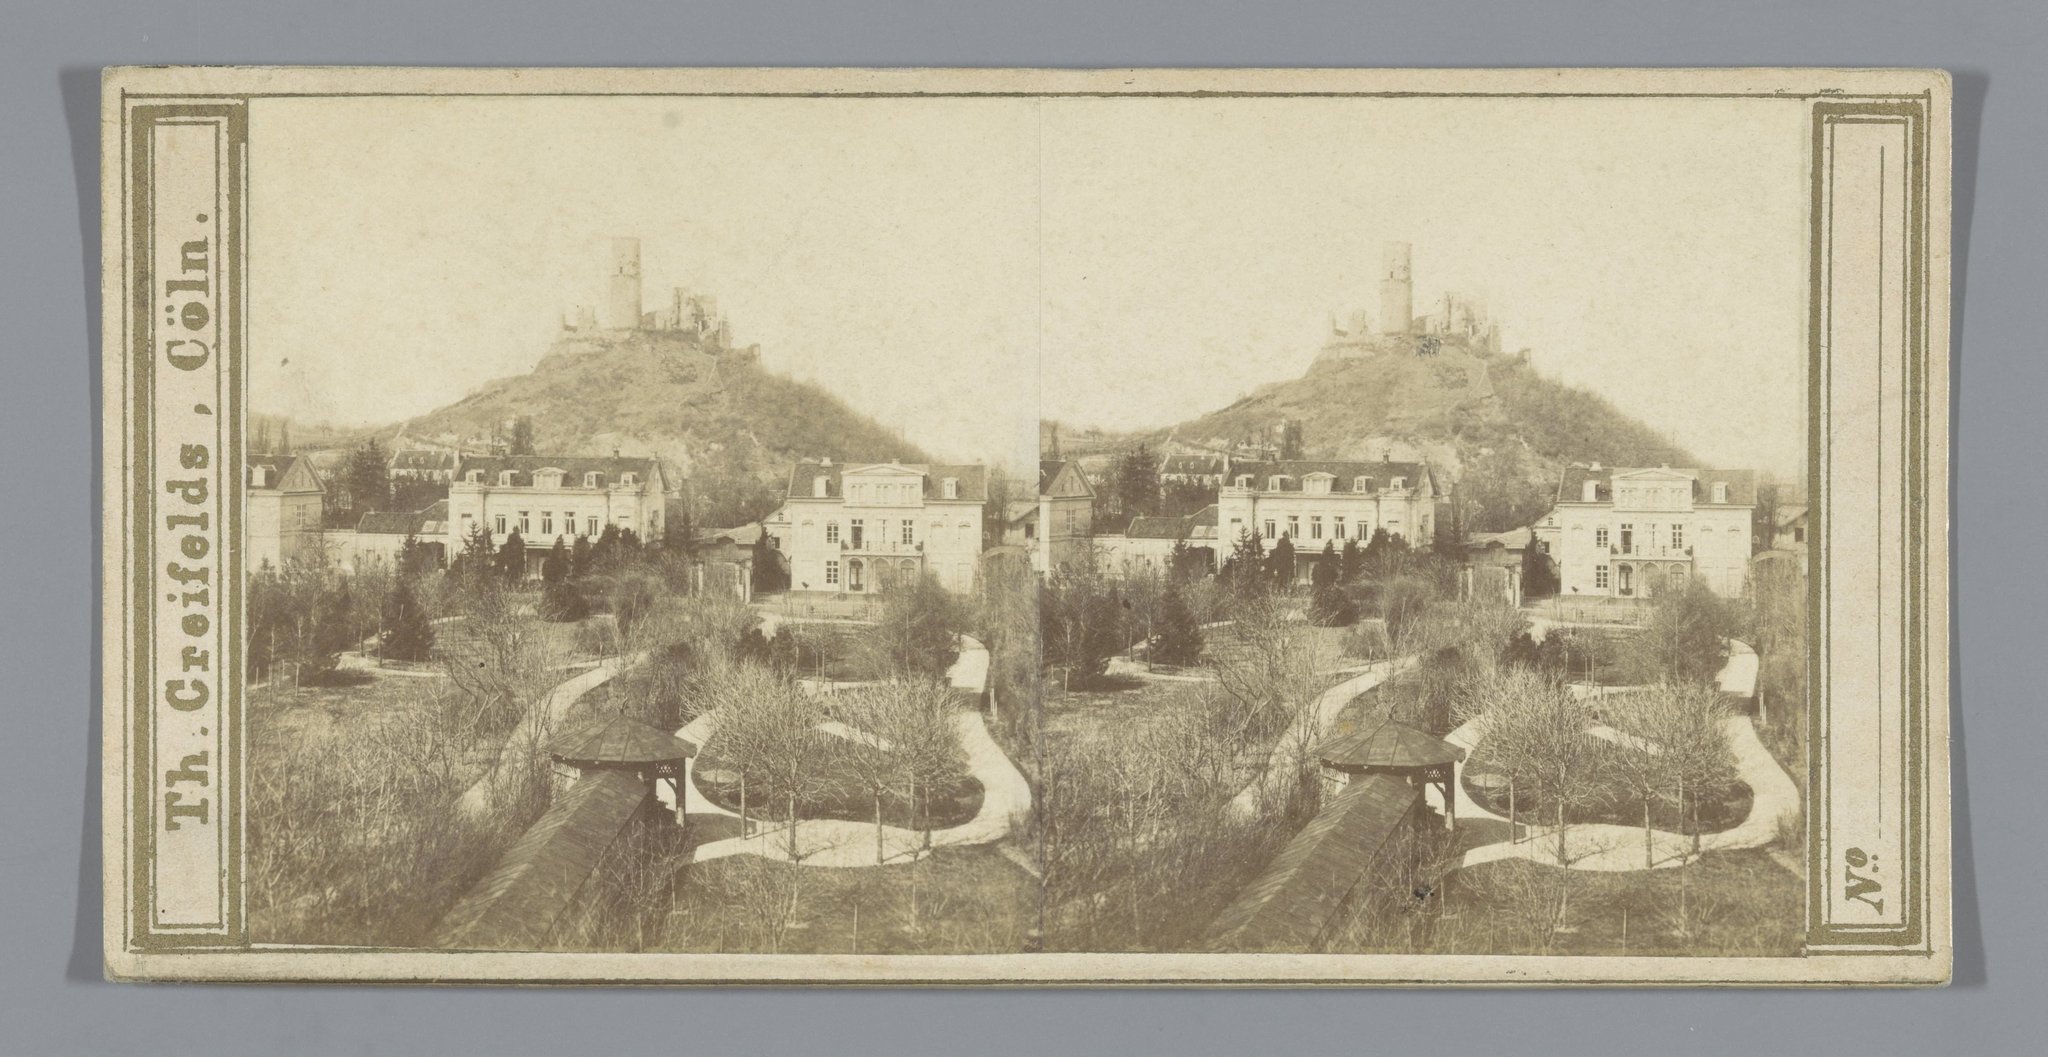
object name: stereograph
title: Gezicht op Bad Godesberg en de ruïne van de Godesburg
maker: theodor creifelds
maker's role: publisher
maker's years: 1815-1875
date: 1857-1863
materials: cardboard, paper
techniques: albumen print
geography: cologne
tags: landscape with ruins, landscape with tower or castle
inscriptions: number: ‘Nro. 74.’, inscription: ‘No’